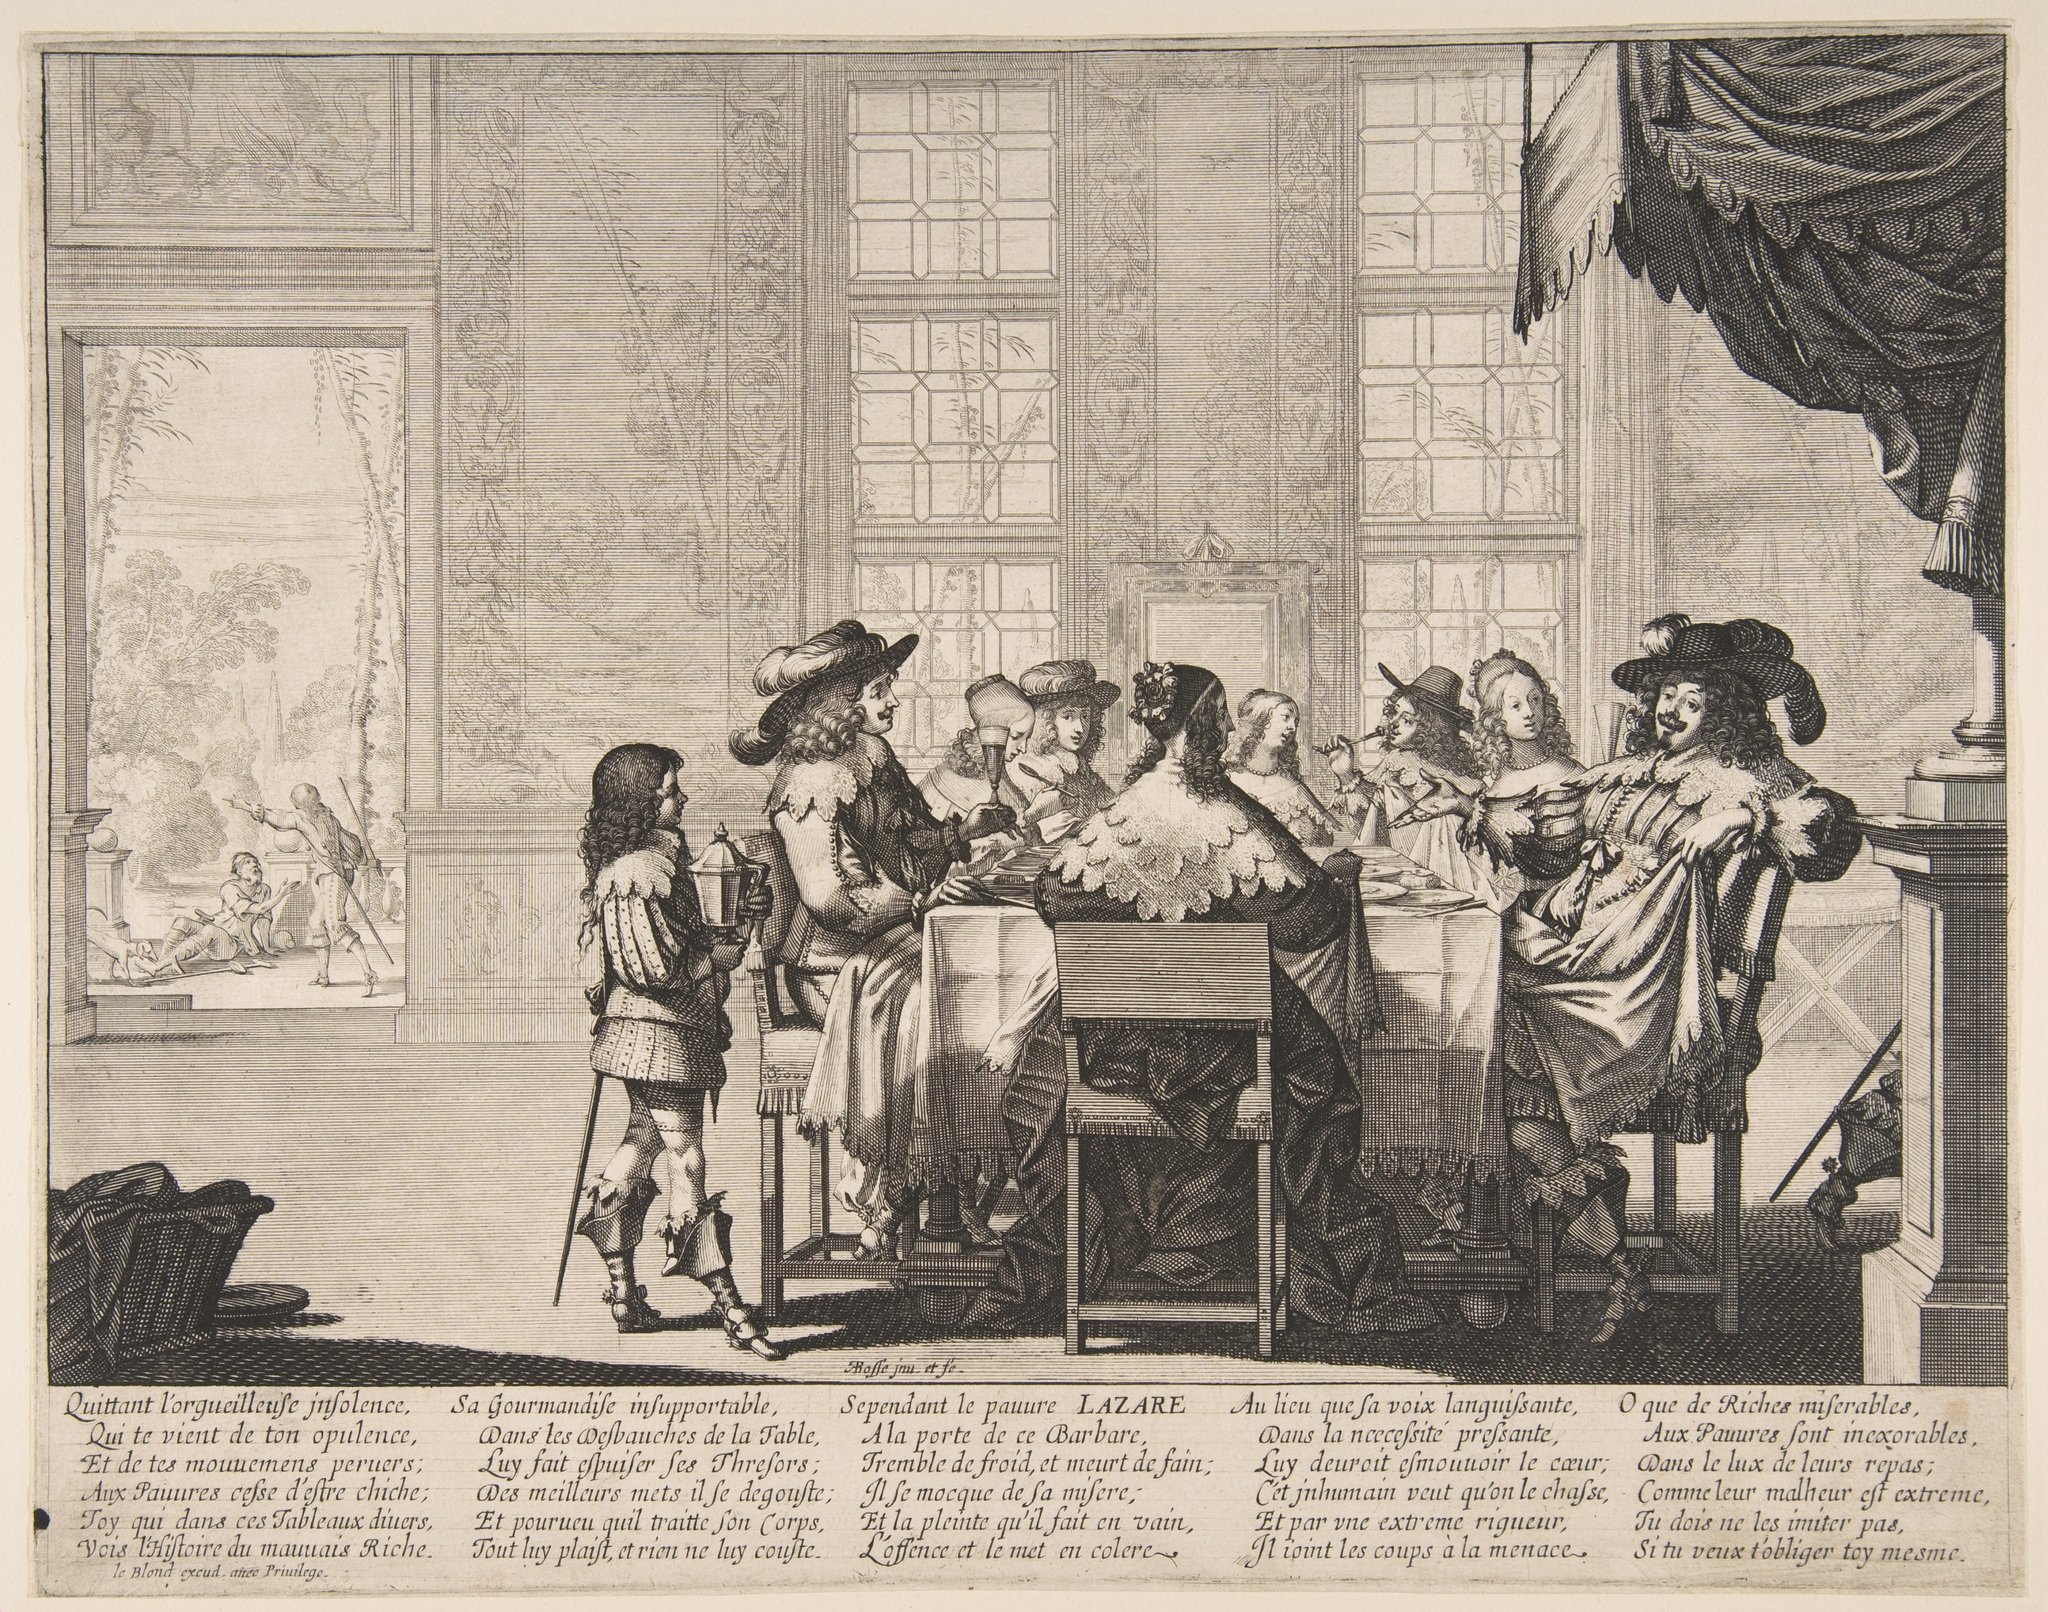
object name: print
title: The Banquet of the Rich Man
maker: abraham bosse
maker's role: artist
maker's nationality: french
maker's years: 1602-1676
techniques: etching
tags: girls,men,women,dining